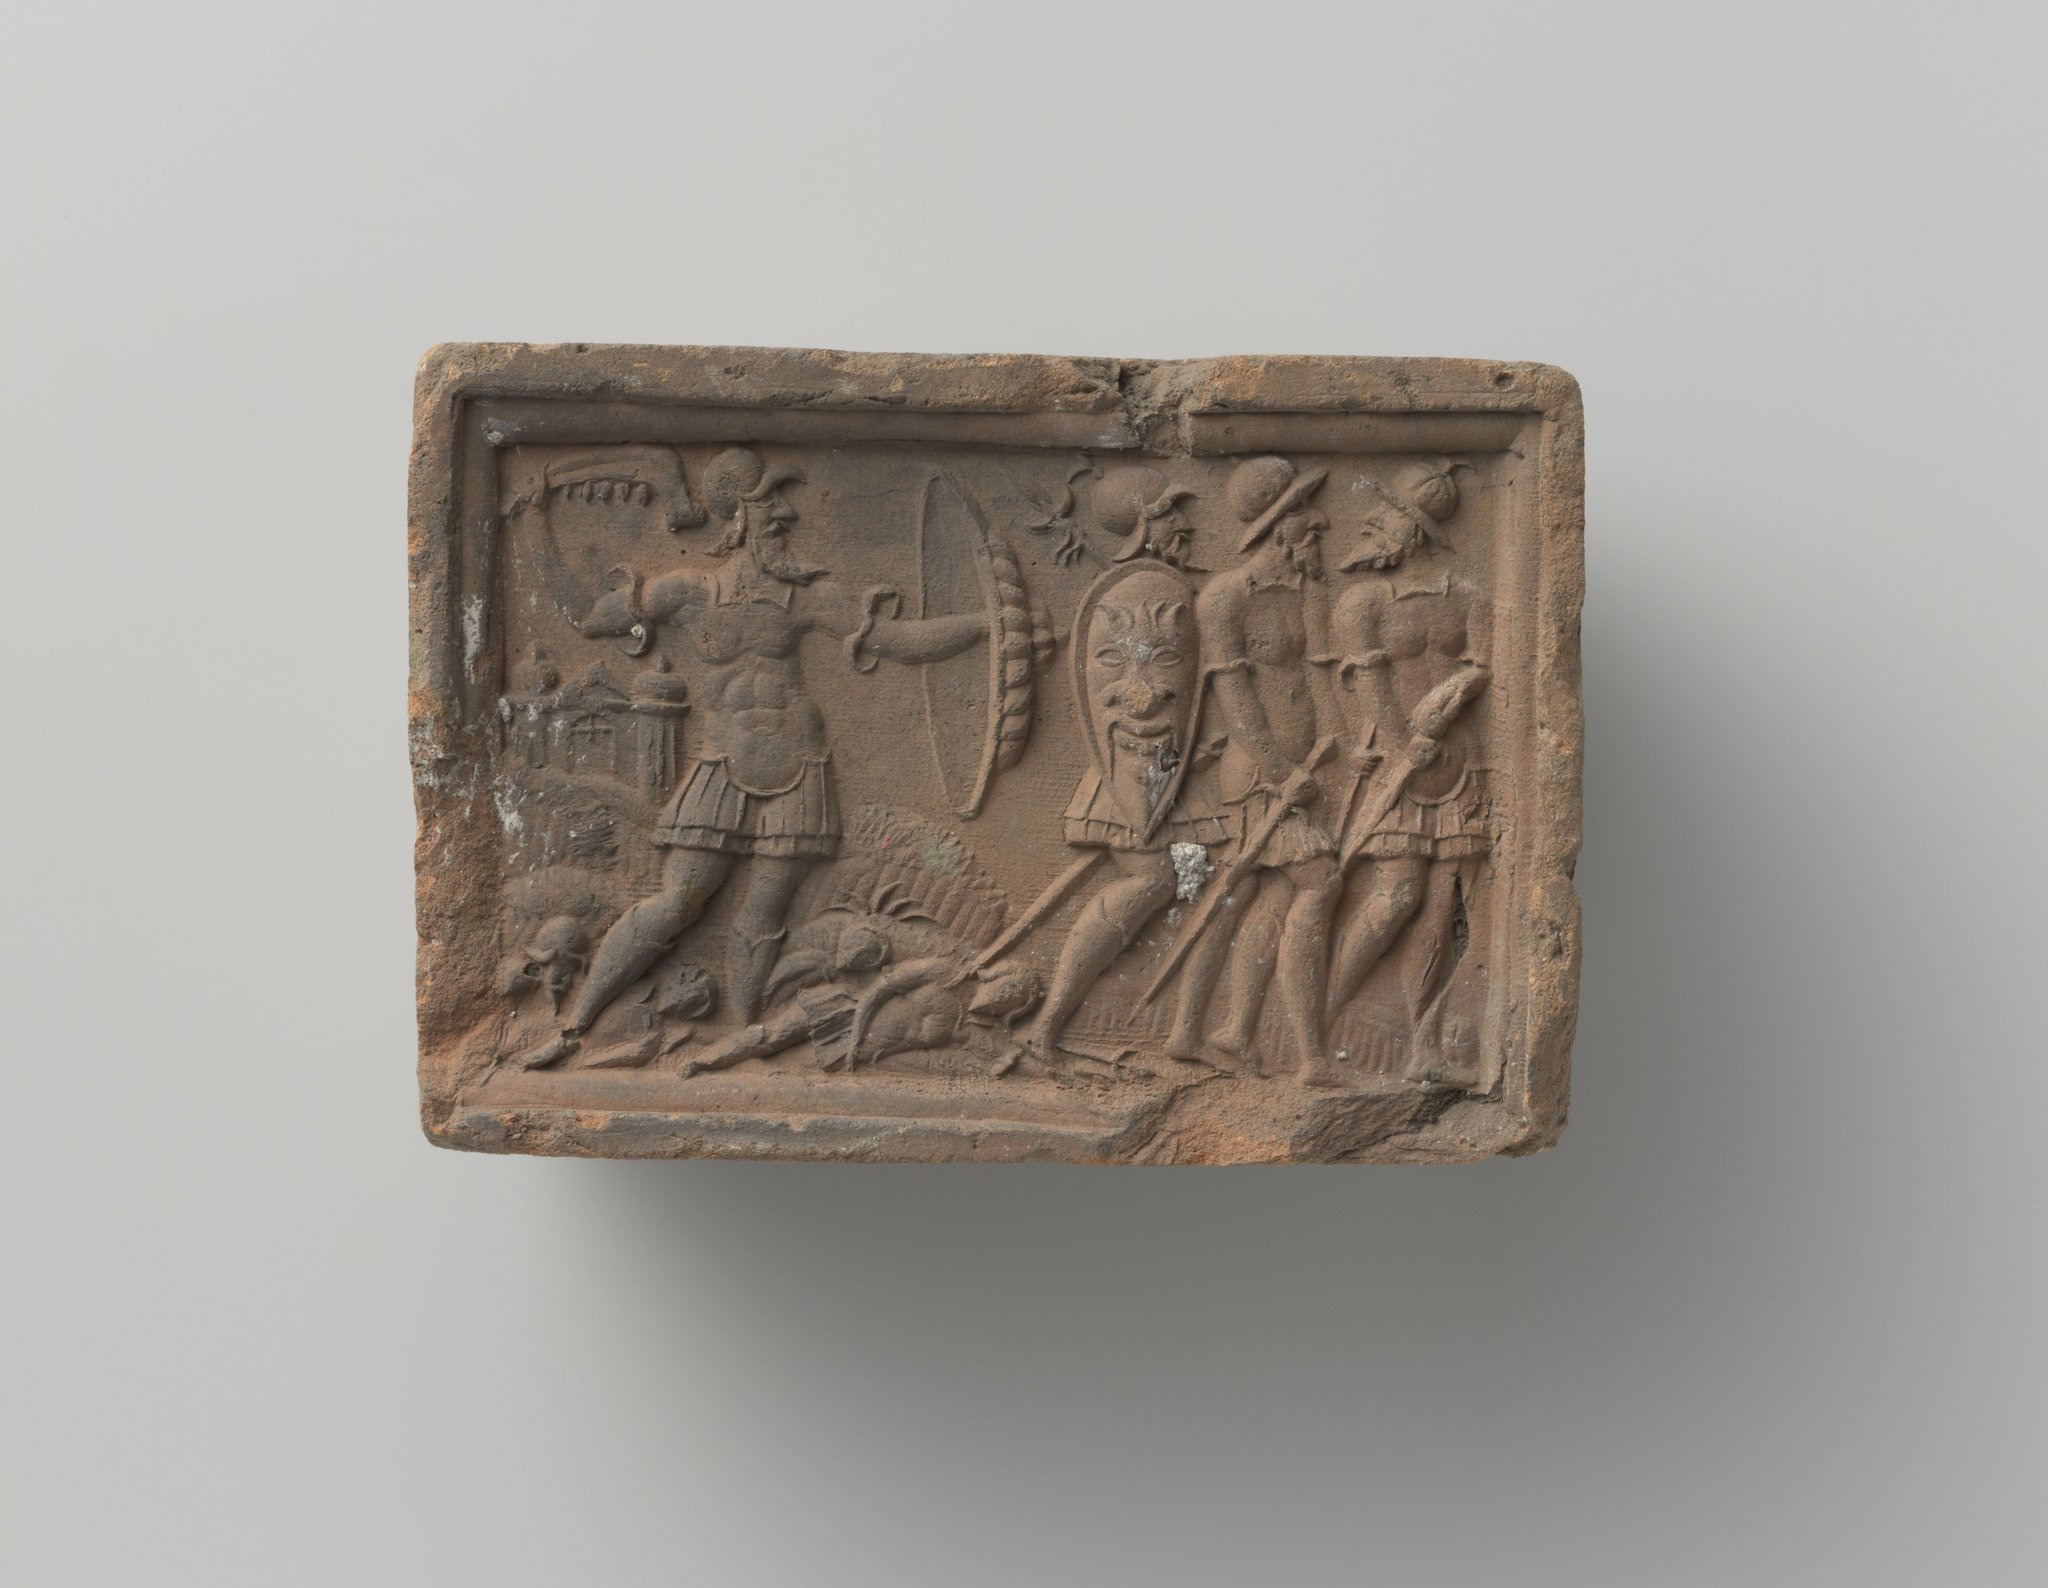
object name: hearthstone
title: Haardsteen met afbeelding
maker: Anonymous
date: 1400-1950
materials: earthenware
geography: southern netherlands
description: Haardsteen. "Samson met het kinnebakken".